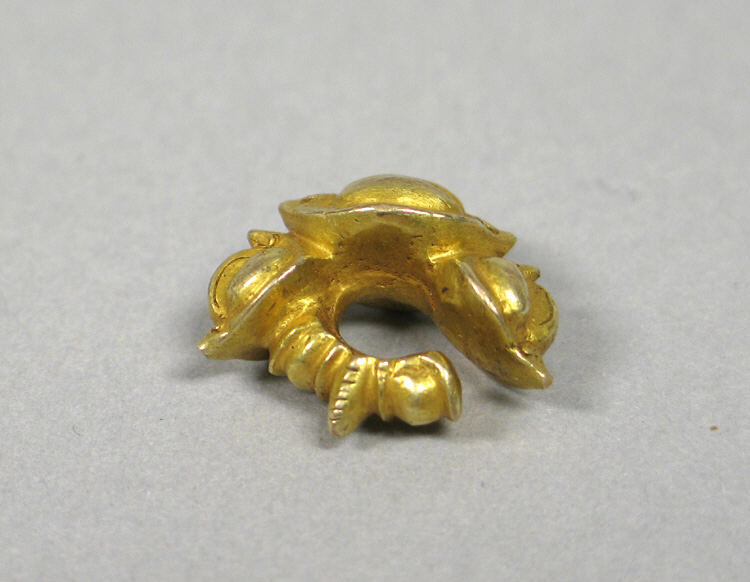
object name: ornament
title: Ornament in the Form of a Bud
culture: indonesian, central java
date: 701-1200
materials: gold